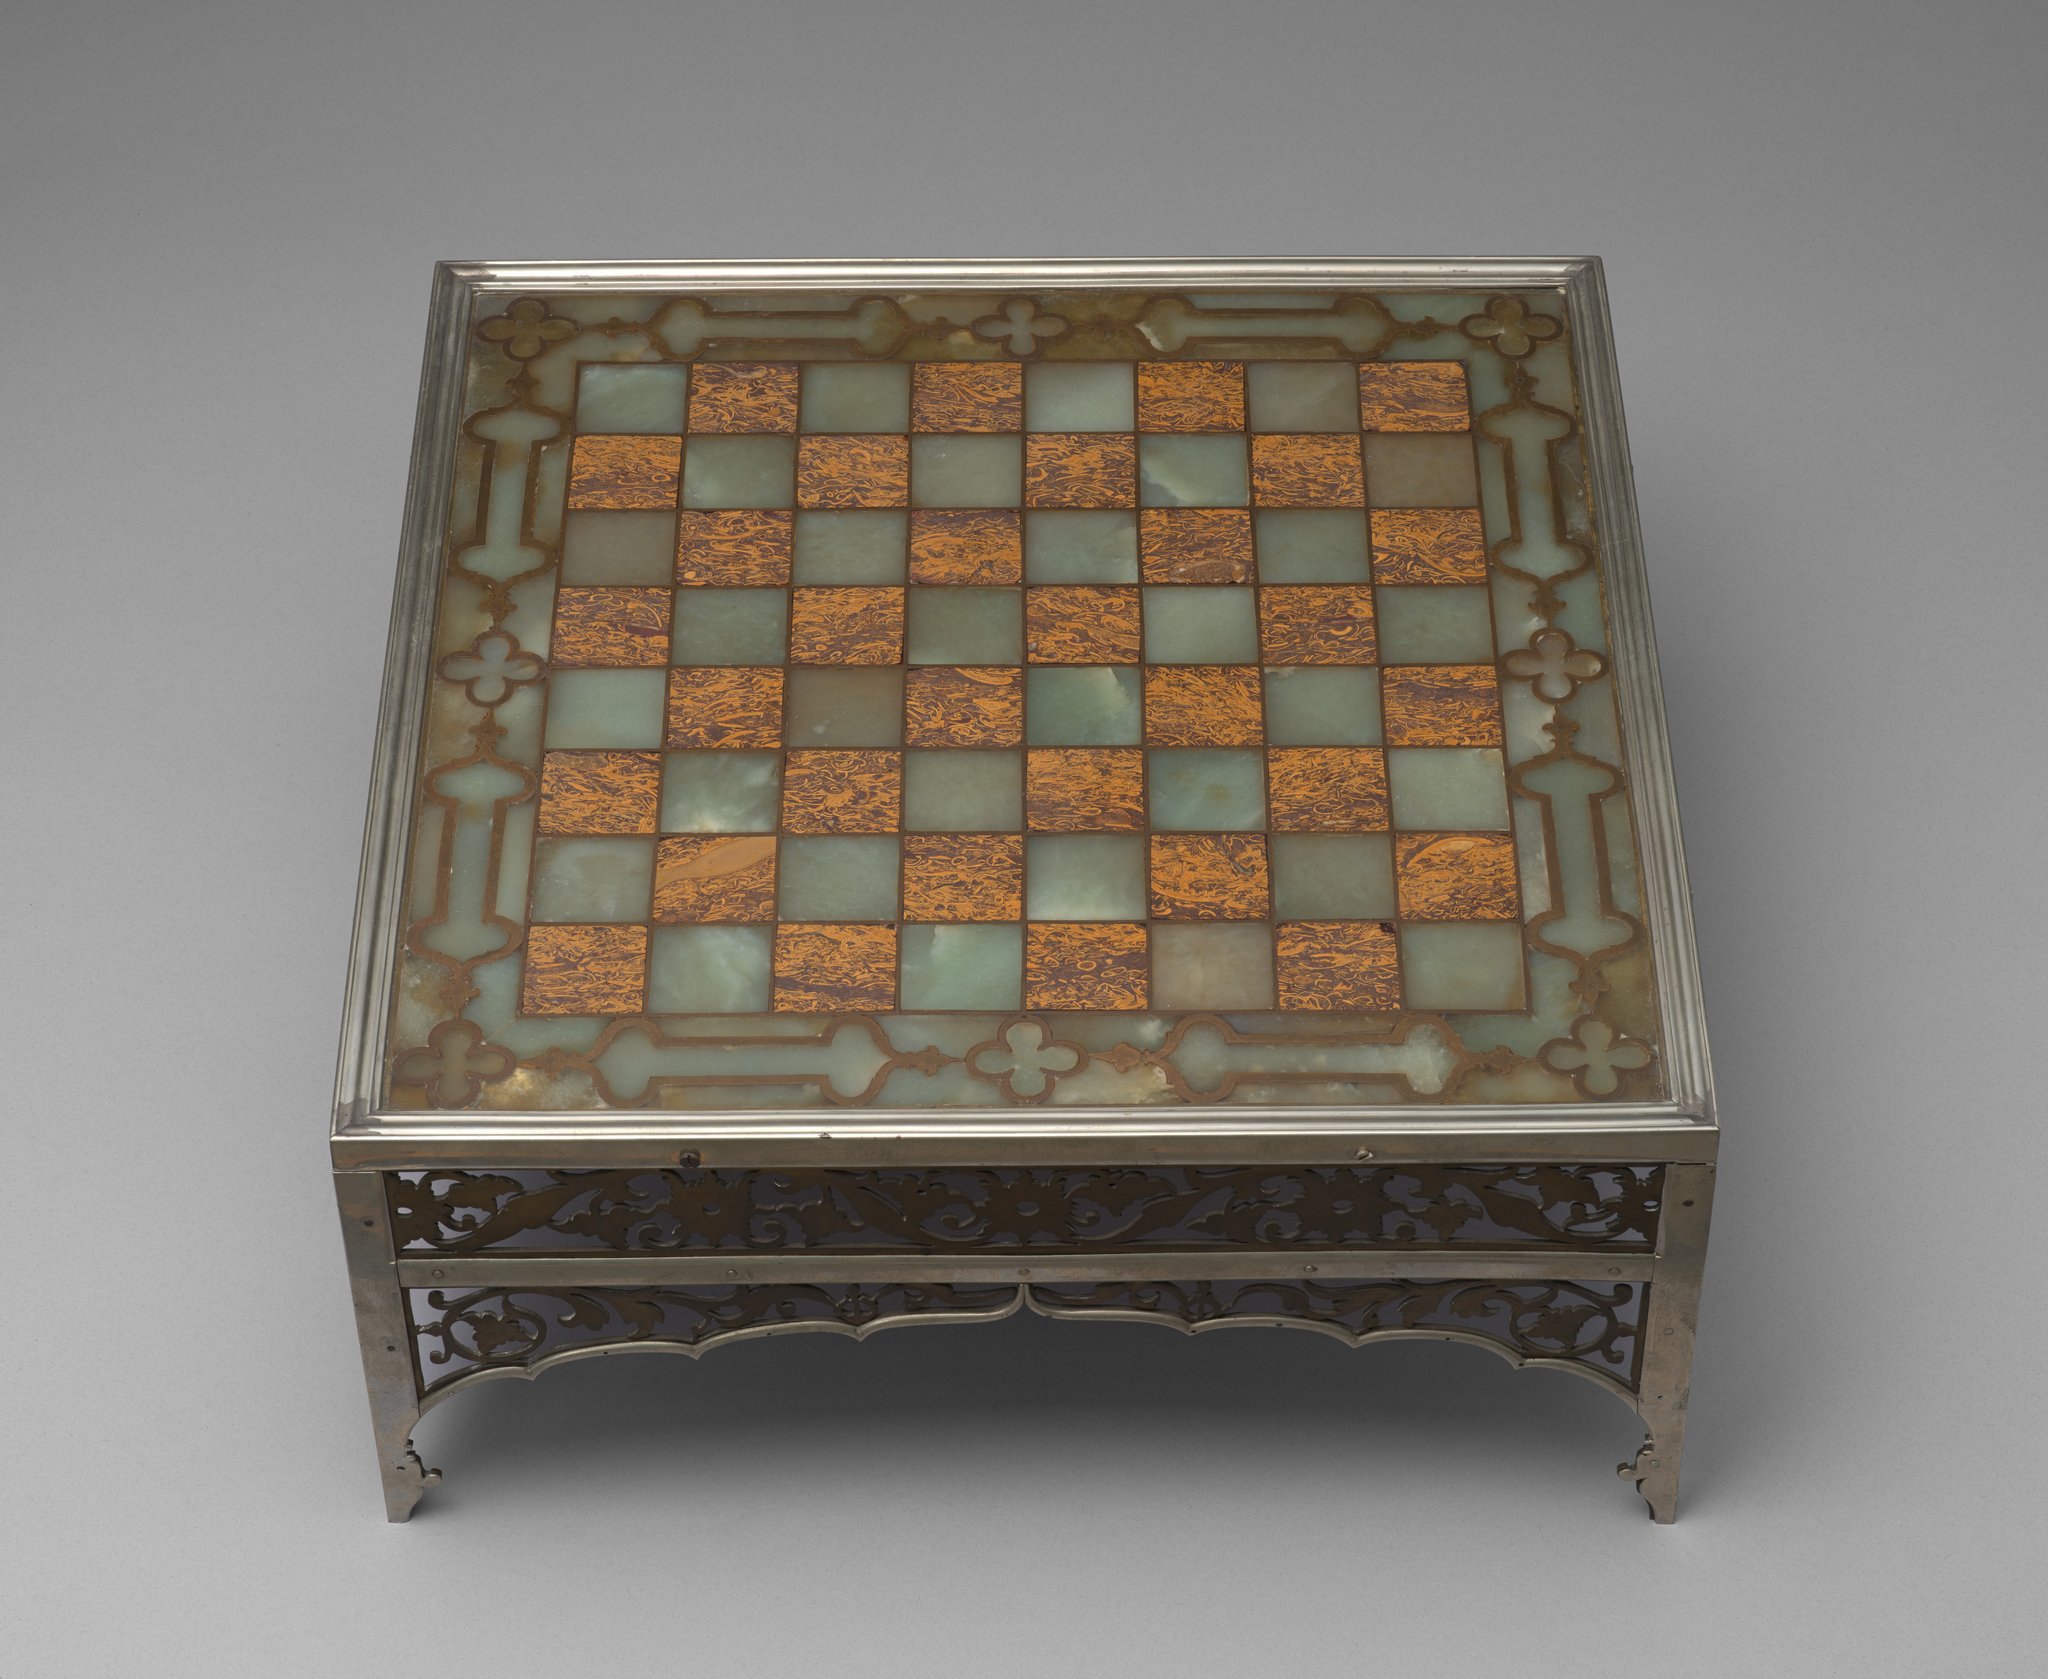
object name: chess table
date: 1801-1900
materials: brass, jade, steel